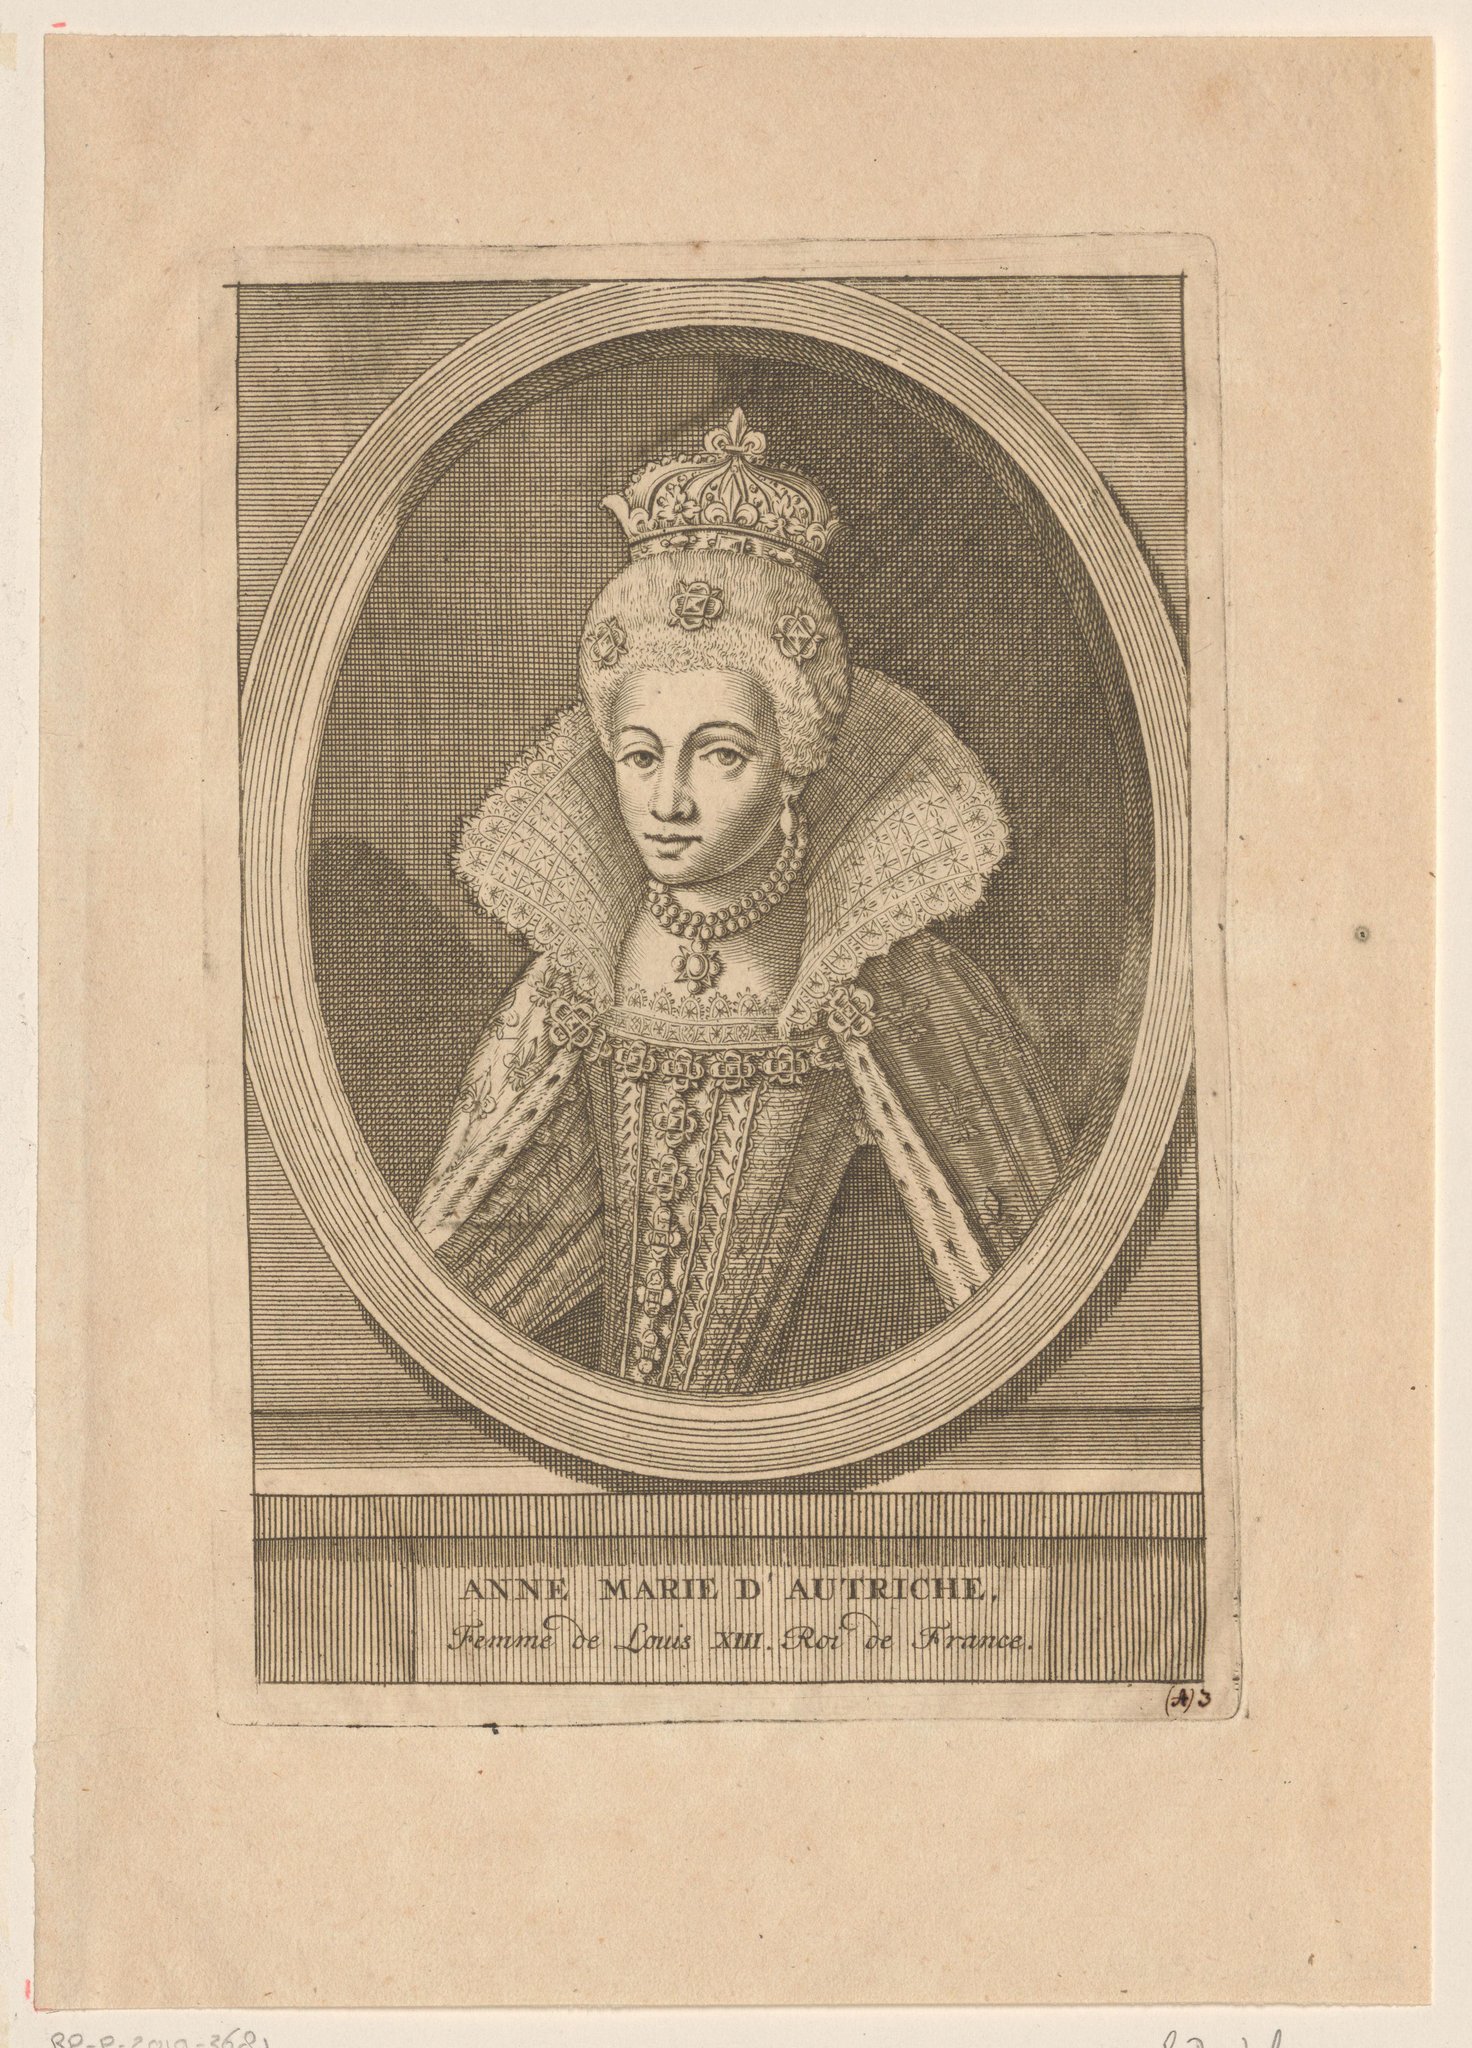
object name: print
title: Portret van Anna van Oostenrijk, koningin van Frankrijk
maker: Anonymous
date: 1615-1643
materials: paper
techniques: engraving, etching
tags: paris, anna van oostenrijk (koningin van frankrijk), historical persons - bb - woman, insignia and symbols of sovereignty (crown, diadem, sceptre, orb, seal, standard, cloak, pectoral) - bb - female ruler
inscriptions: inscription: ‘(A)3’